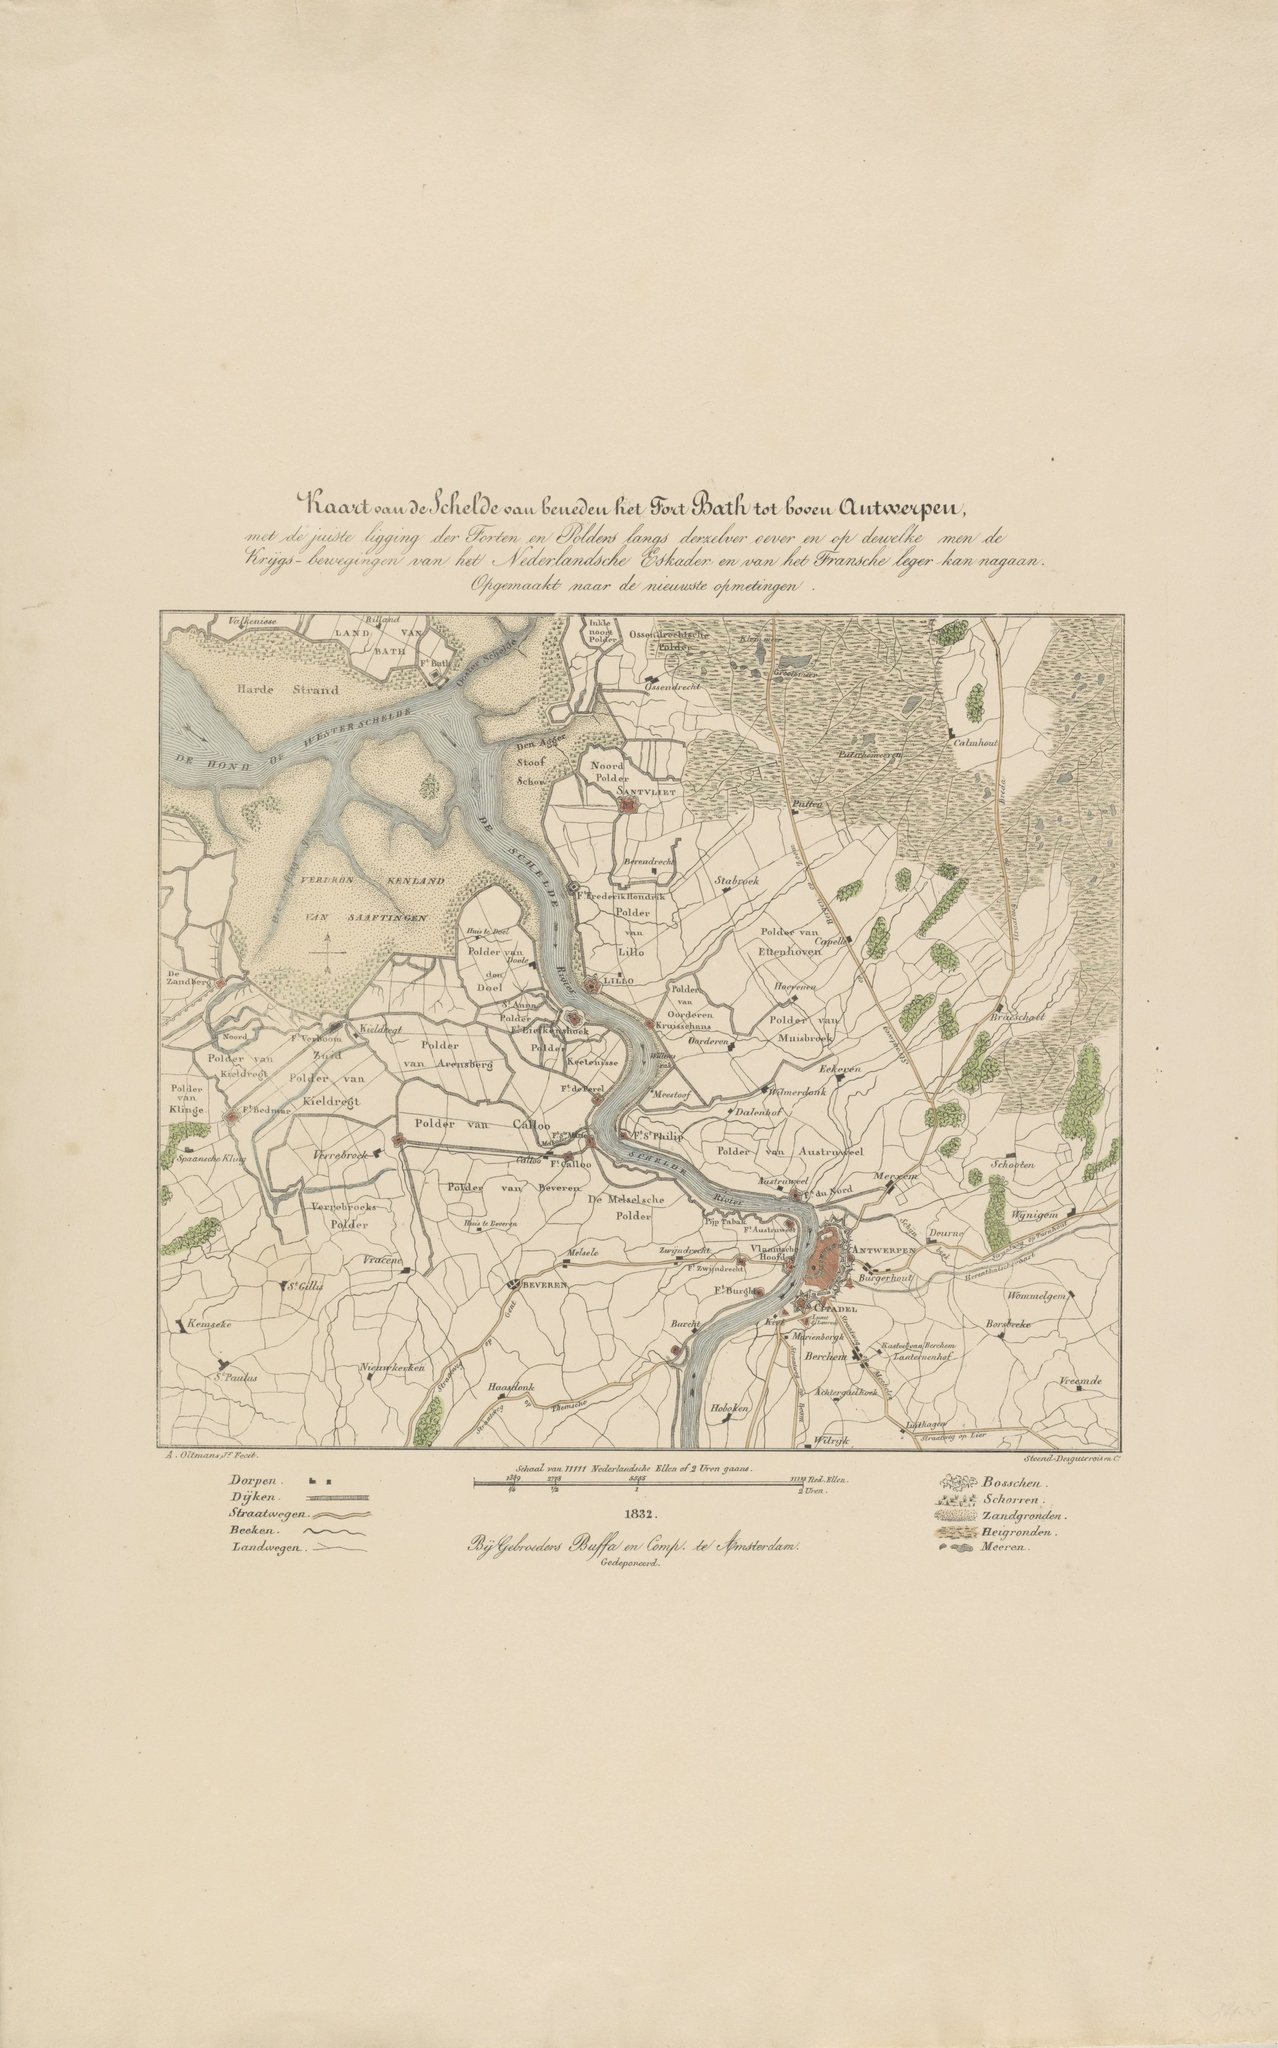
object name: map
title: Kaart van de Schelde van beneden het Fort Bath tot boven Antwerpen, met de juiste ligging der Forten en Polders langs derzelver oever en op dewelke men de Krijgs-bewegingen van het Nederlandsche Eskader en van het Fransche leger kan nagaan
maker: alexander oltmans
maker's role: draughtsman, print maker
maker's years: 1814-1853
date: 1832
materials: paper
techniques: hand coloring, lithograph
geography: amsterdam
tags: maps of separate countries or regions, antwerp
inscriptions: collector's mark: Lugt 2228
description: Kaart van de loop van de Schelde vanaf Fort Bath tot aan Antwerpen. In verband met het beleg van de Citadel van Antwerpen door het Franse leger, december 1832. Onderaan een schaalstok en legenda van de gebruikte symbolen.